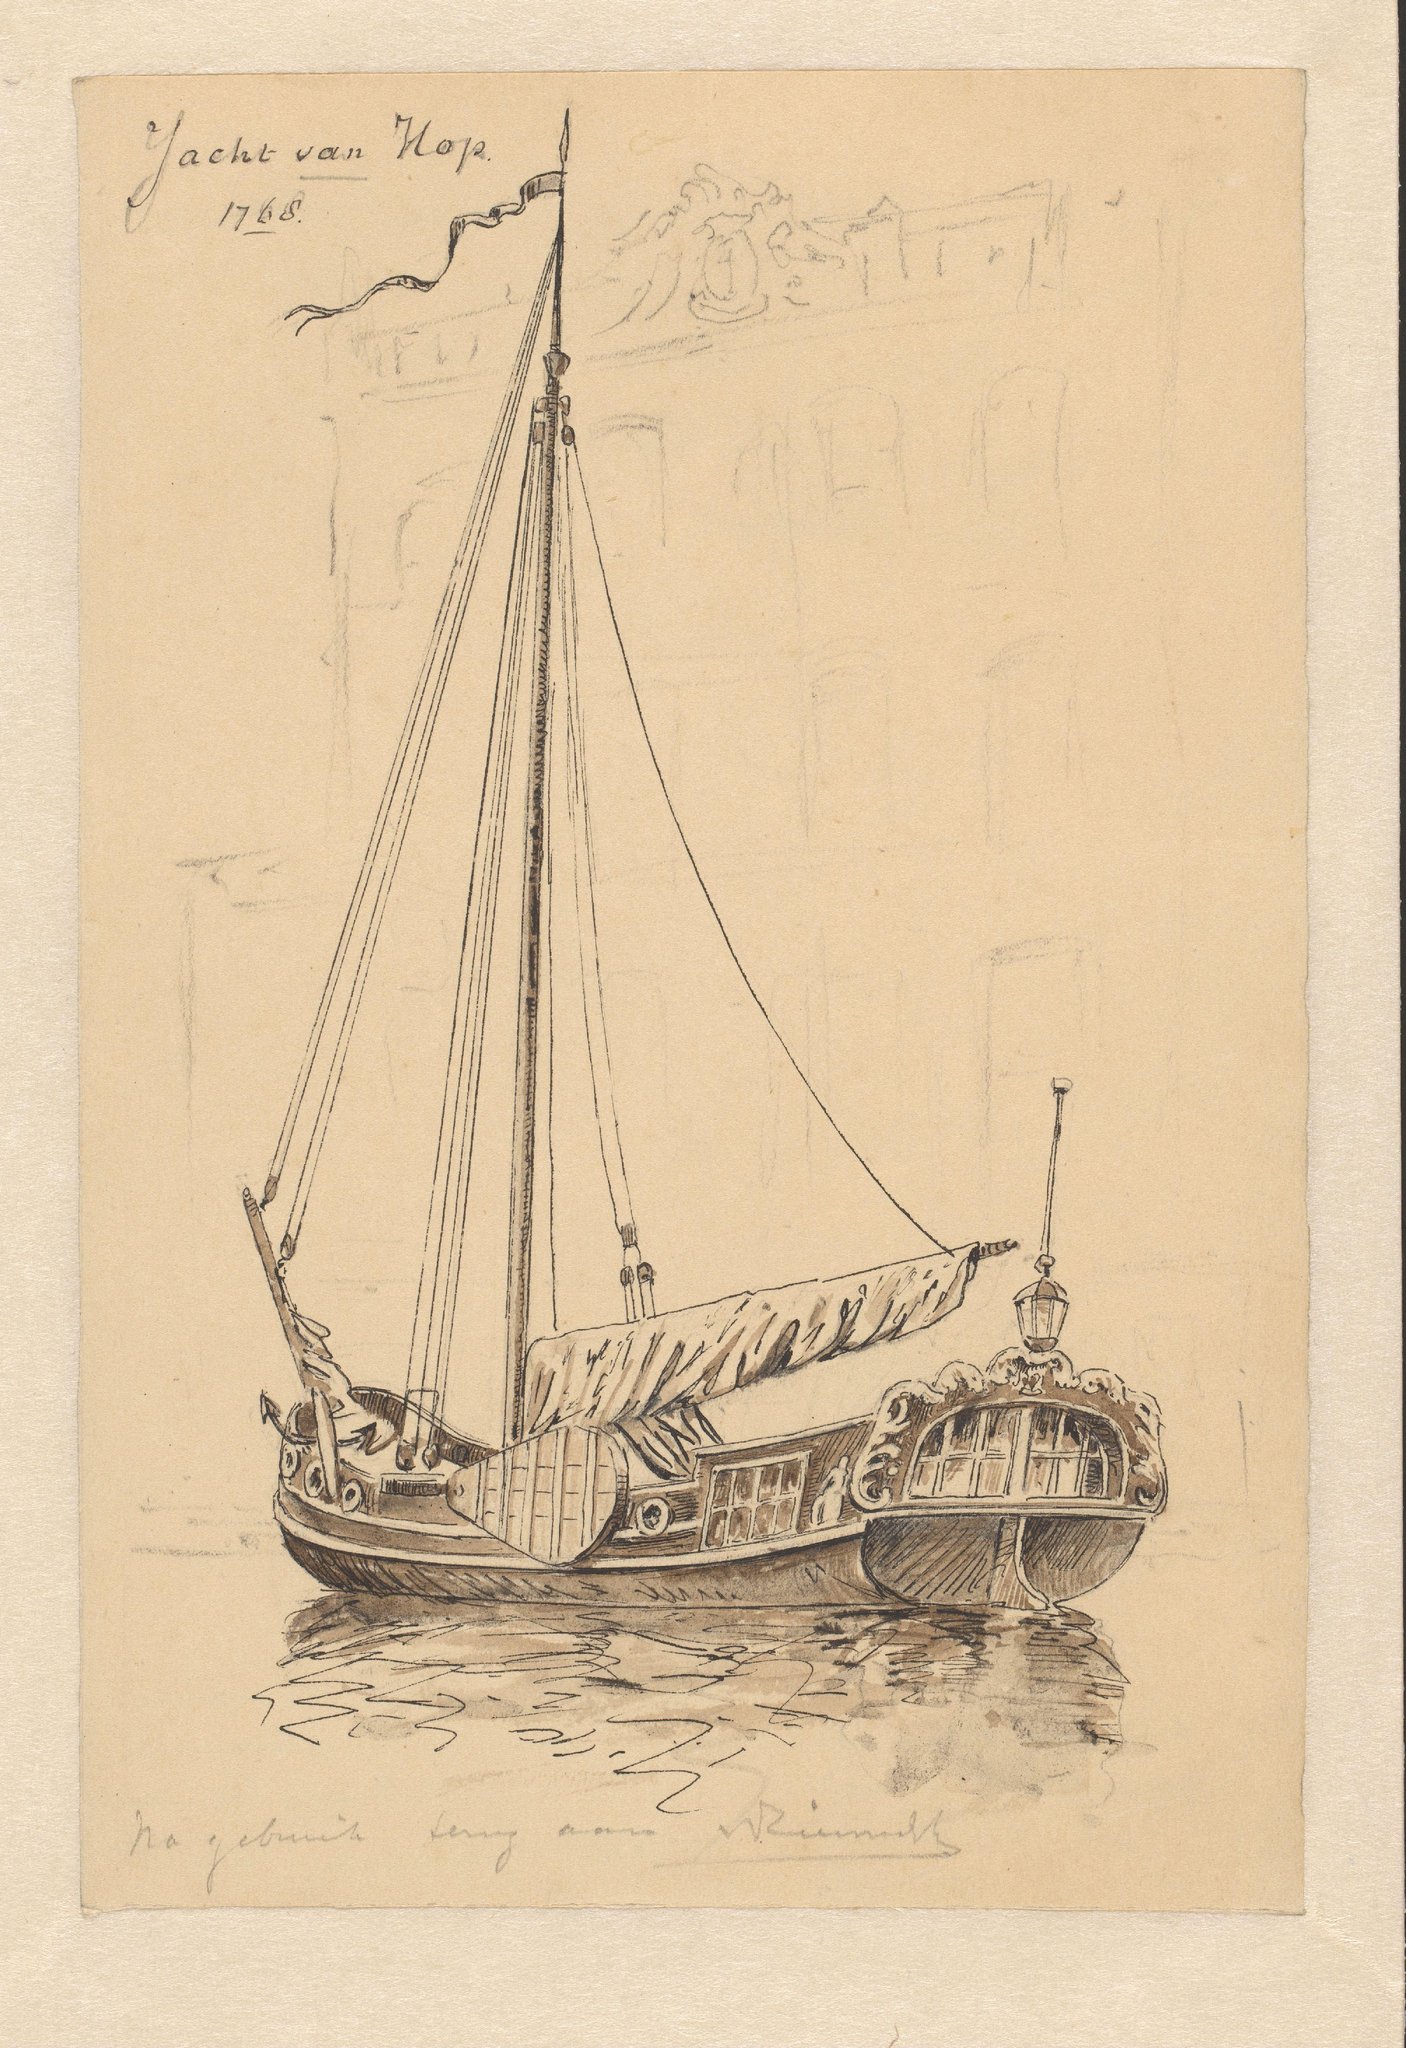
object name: drawing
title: Jacht van Hop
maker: jan hoynck van papendrecht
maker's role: draughtsman, painter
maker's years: 1858-1933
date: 1895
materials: ink, paper, pencil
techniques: brush, pen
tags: sailing-ship, sailing-boat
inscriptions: annotation: ‘Na gebruik terug aan [...]’, date: ‘Mei 1895.’, inscription: ‘Copie van een schilderijtje in goud op glas. Het origineel/ behoort aan Baron Brantsen van Wielbergen. Huize Rhederoord/ (de Steeg). De copie is van de hand van J. Hoynck v. Papendrecht’